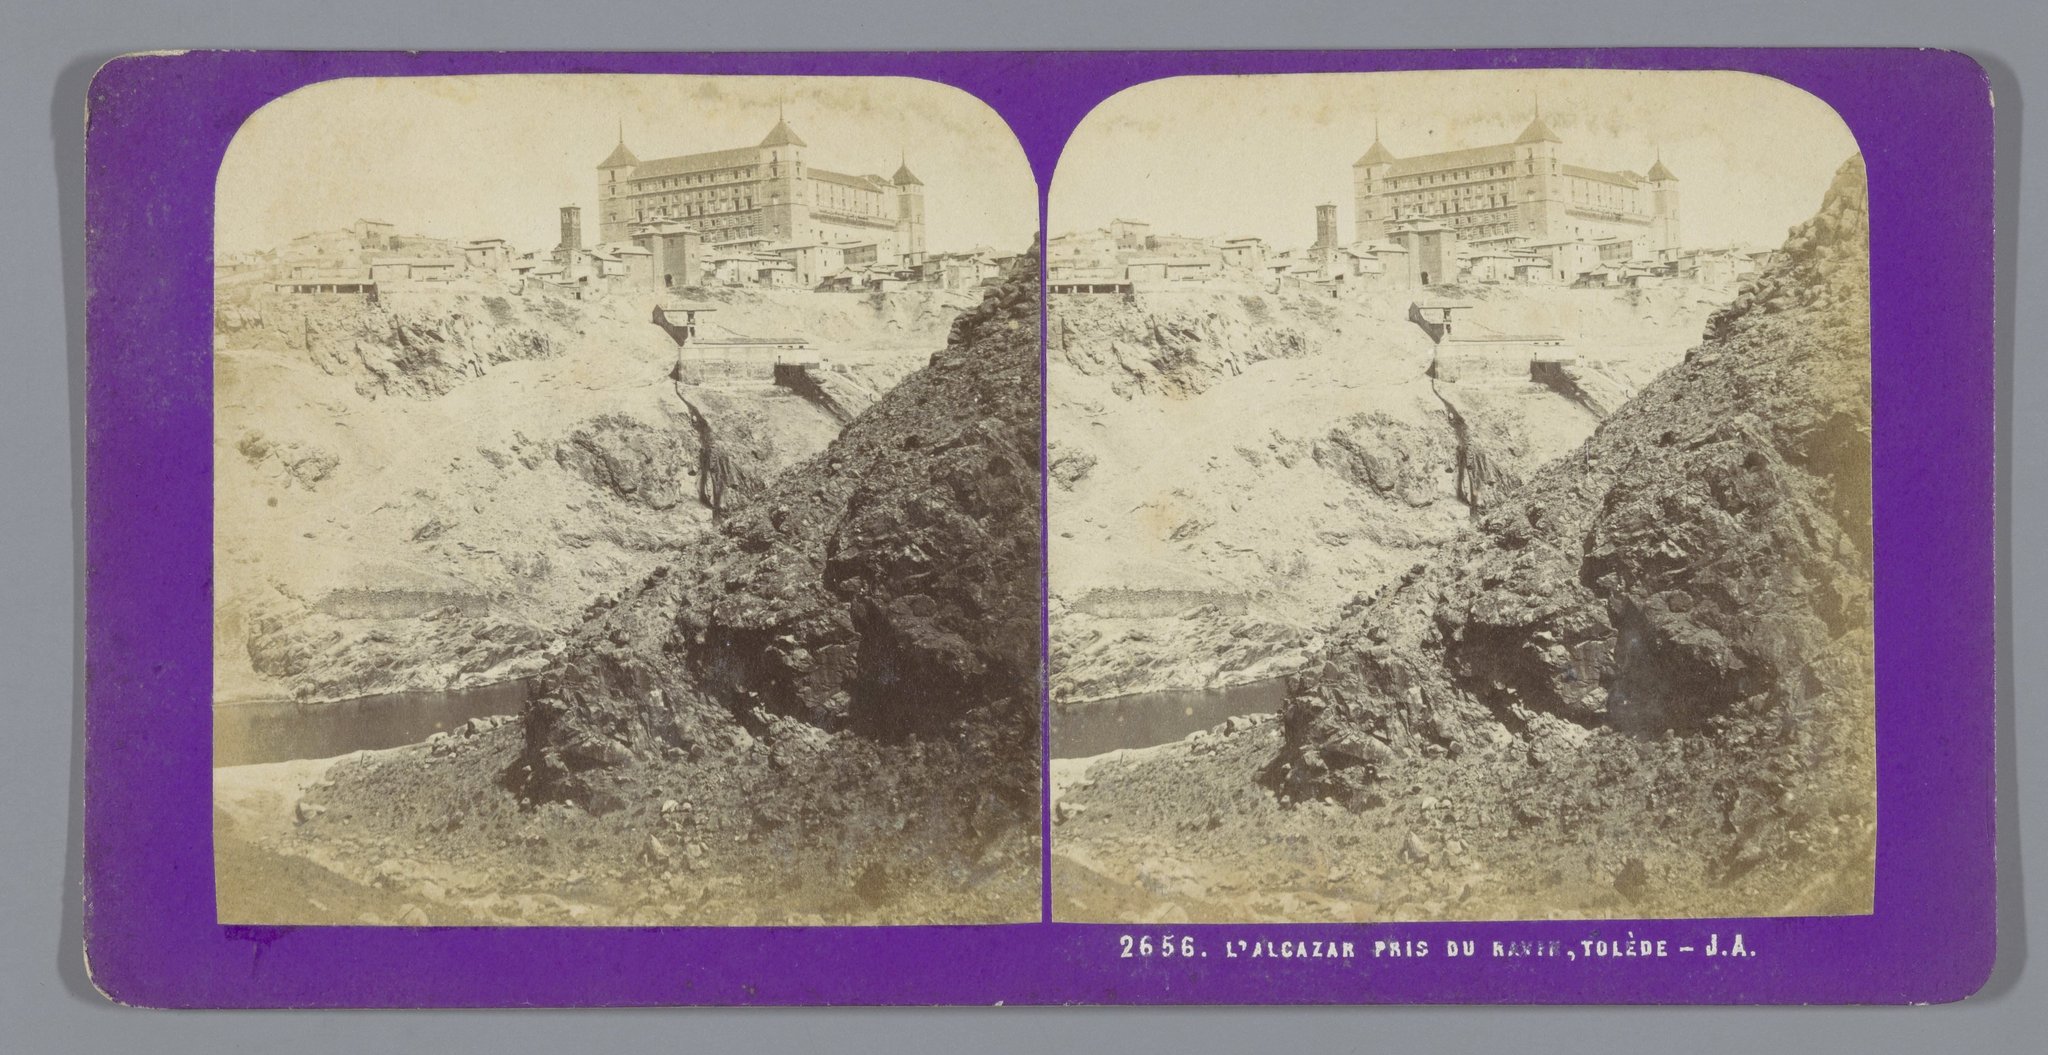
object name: stereograph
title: Gezicht op het Alcázar van Toledo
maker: jean andrieu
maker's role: fotograaf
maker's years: 1816-1872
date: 1862-1876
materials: cardboard, photographic support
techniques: albumen print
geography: castilla-la mancha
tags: fortress, ravine, chasm, abyss, canyon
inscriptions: number: ‘2656.’